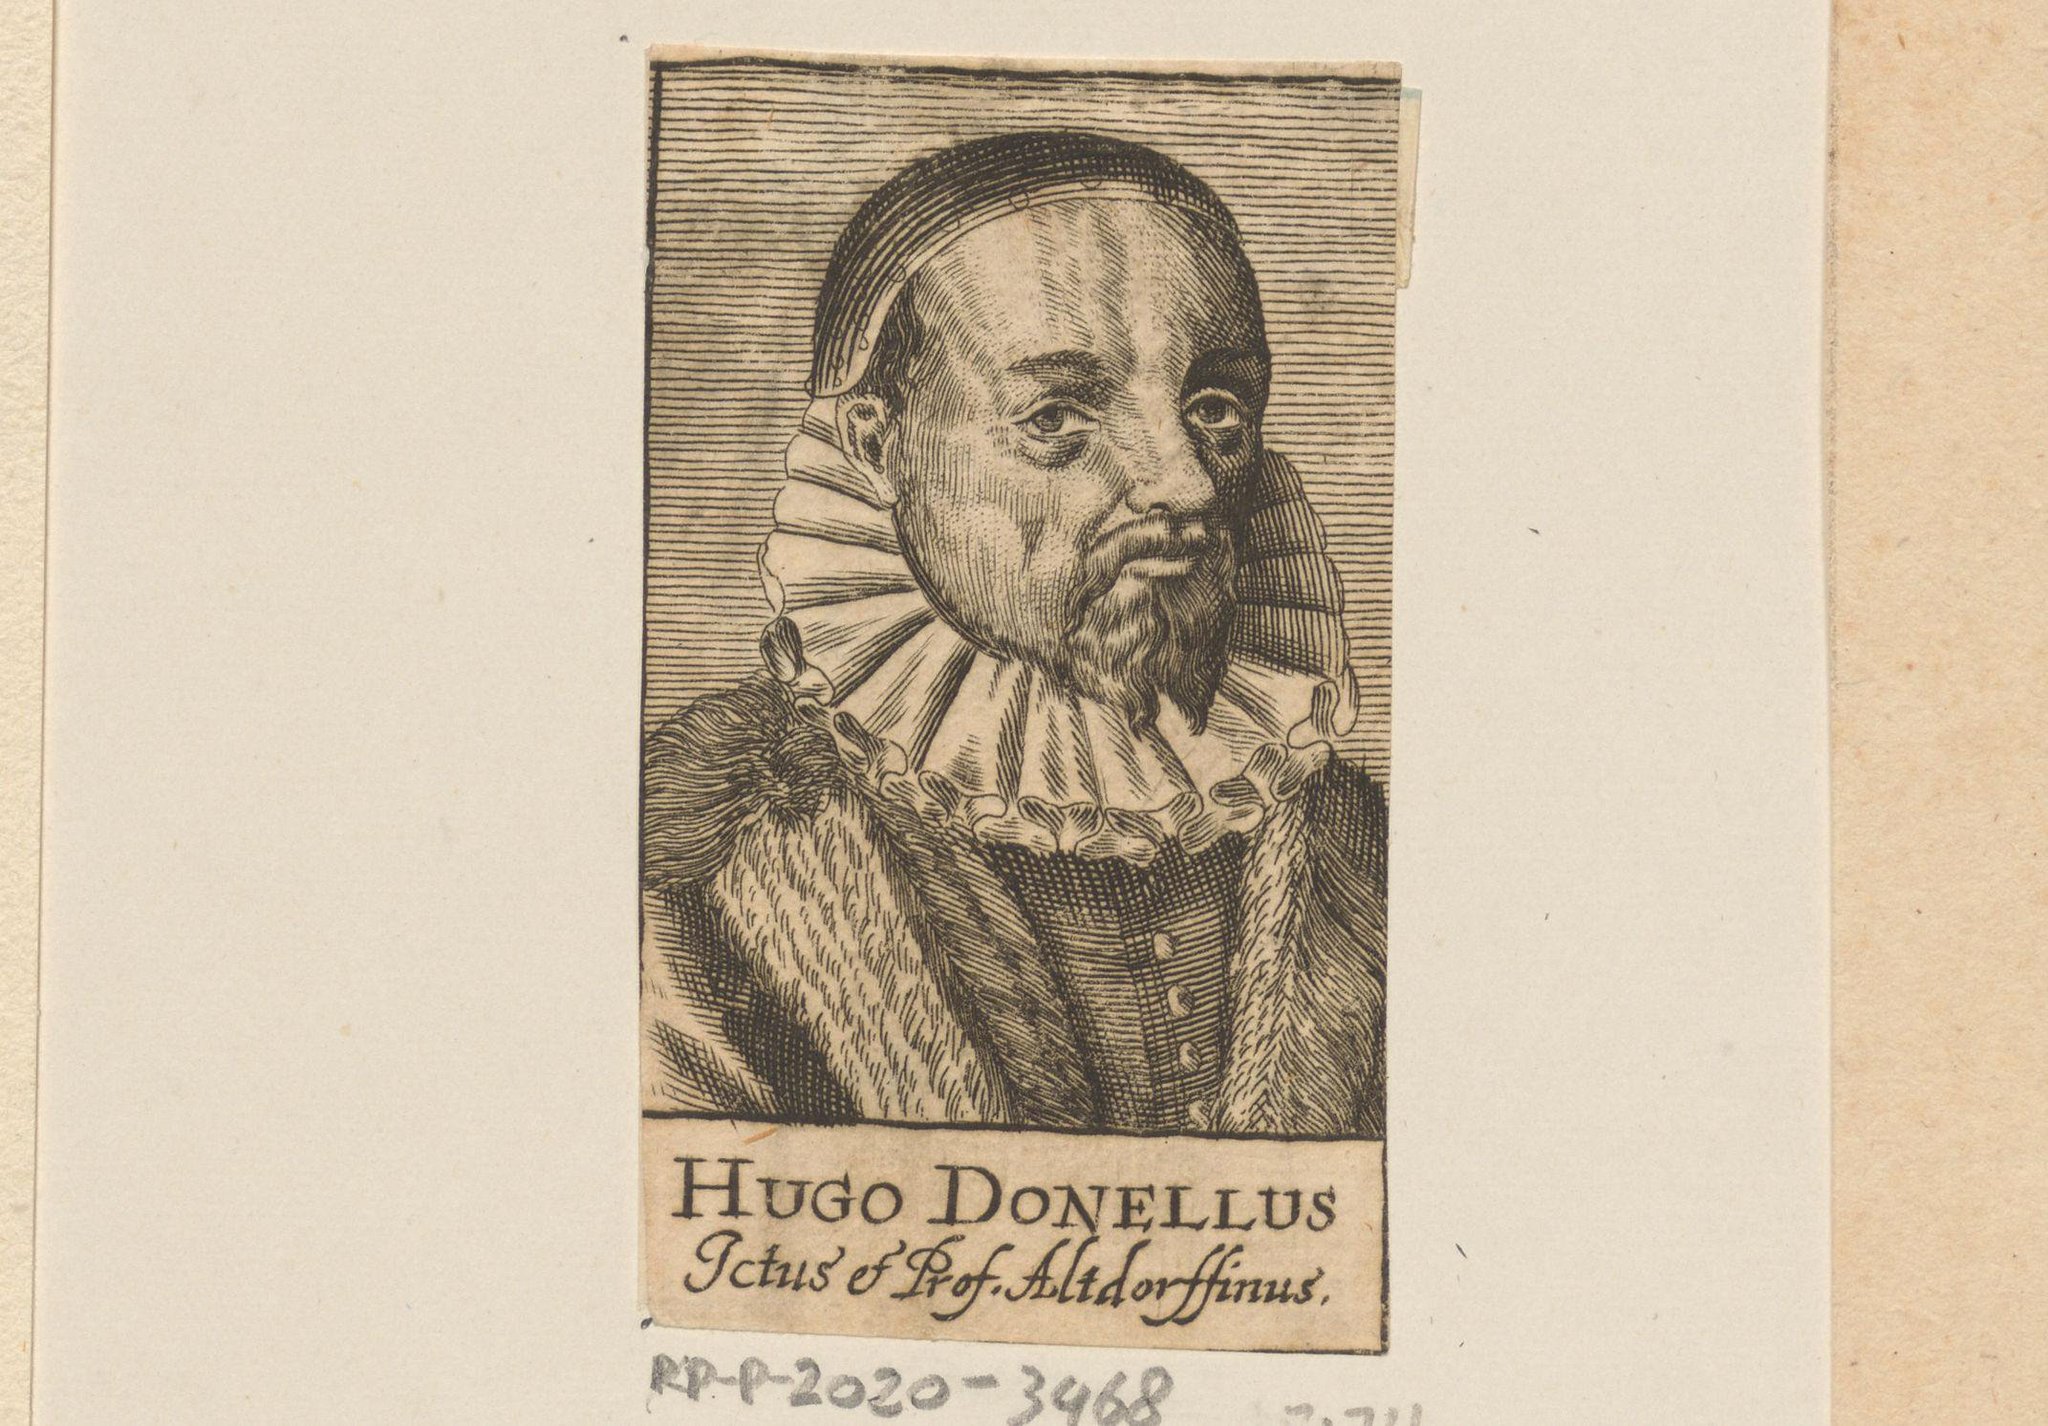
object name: print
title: Portret van Hugo Donellus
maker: Anonymous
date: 1688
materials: paper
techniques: engraving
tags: historical persons, professor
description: Prent maakt deel uit van een grotere prent die later is verknipt. Prent waarschijnlijk uit: Freher, Paul. Theatrum virorum eruditione clarorum. Neurenberg: Johann Hoffmann, 1688